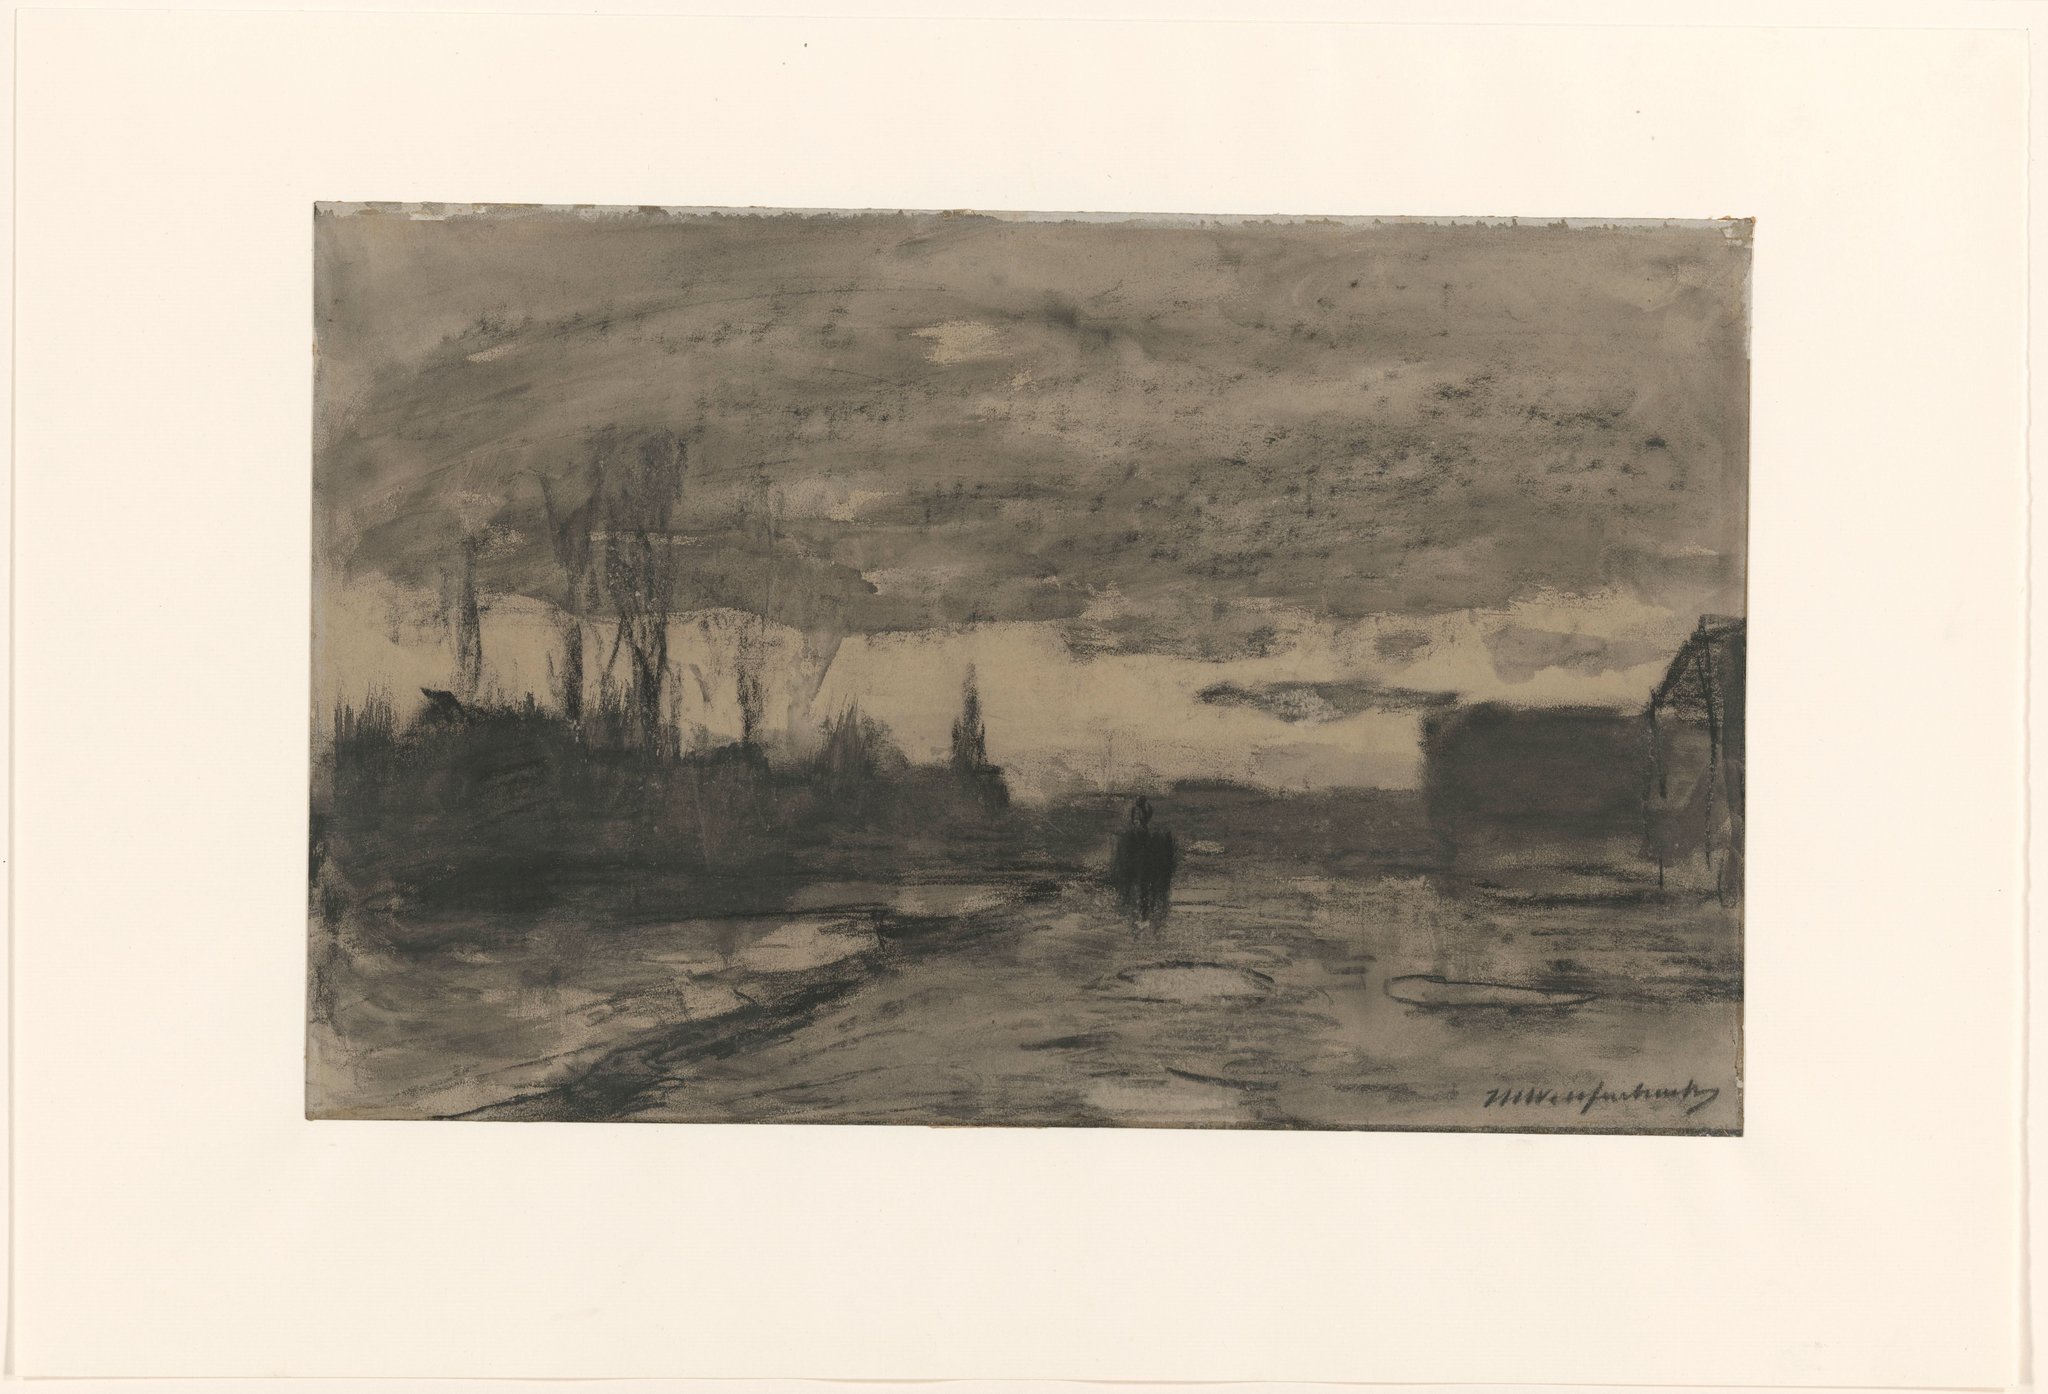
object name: drawing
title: Gezicht op een kade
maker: johan hendrik weissenbruch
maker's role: draughtsman, painter, print maker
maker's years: 1824-1903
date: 1834-1903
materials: chalk, paper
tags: pier, quay, wharf, quay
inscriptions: signature: ‘J.H. Weissenbruch’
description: Op de achtergrond donkere gebouwen, bomen en een torenspits tegen de lichtende avondhemel.